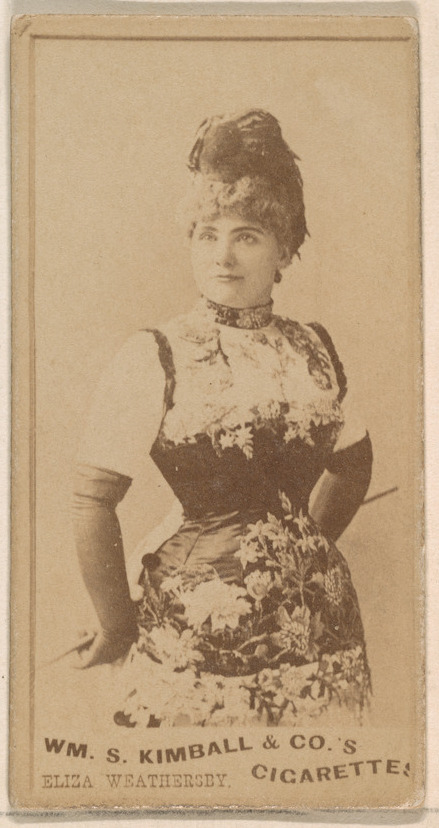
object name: photograph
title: Eliza Weathersby, from the Actresses series (N203) issued by Wm. S. Kimball & Co.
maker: william s. kimball & company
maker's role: publisher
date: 1889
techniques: color lithograph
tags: portraits,women,actresses